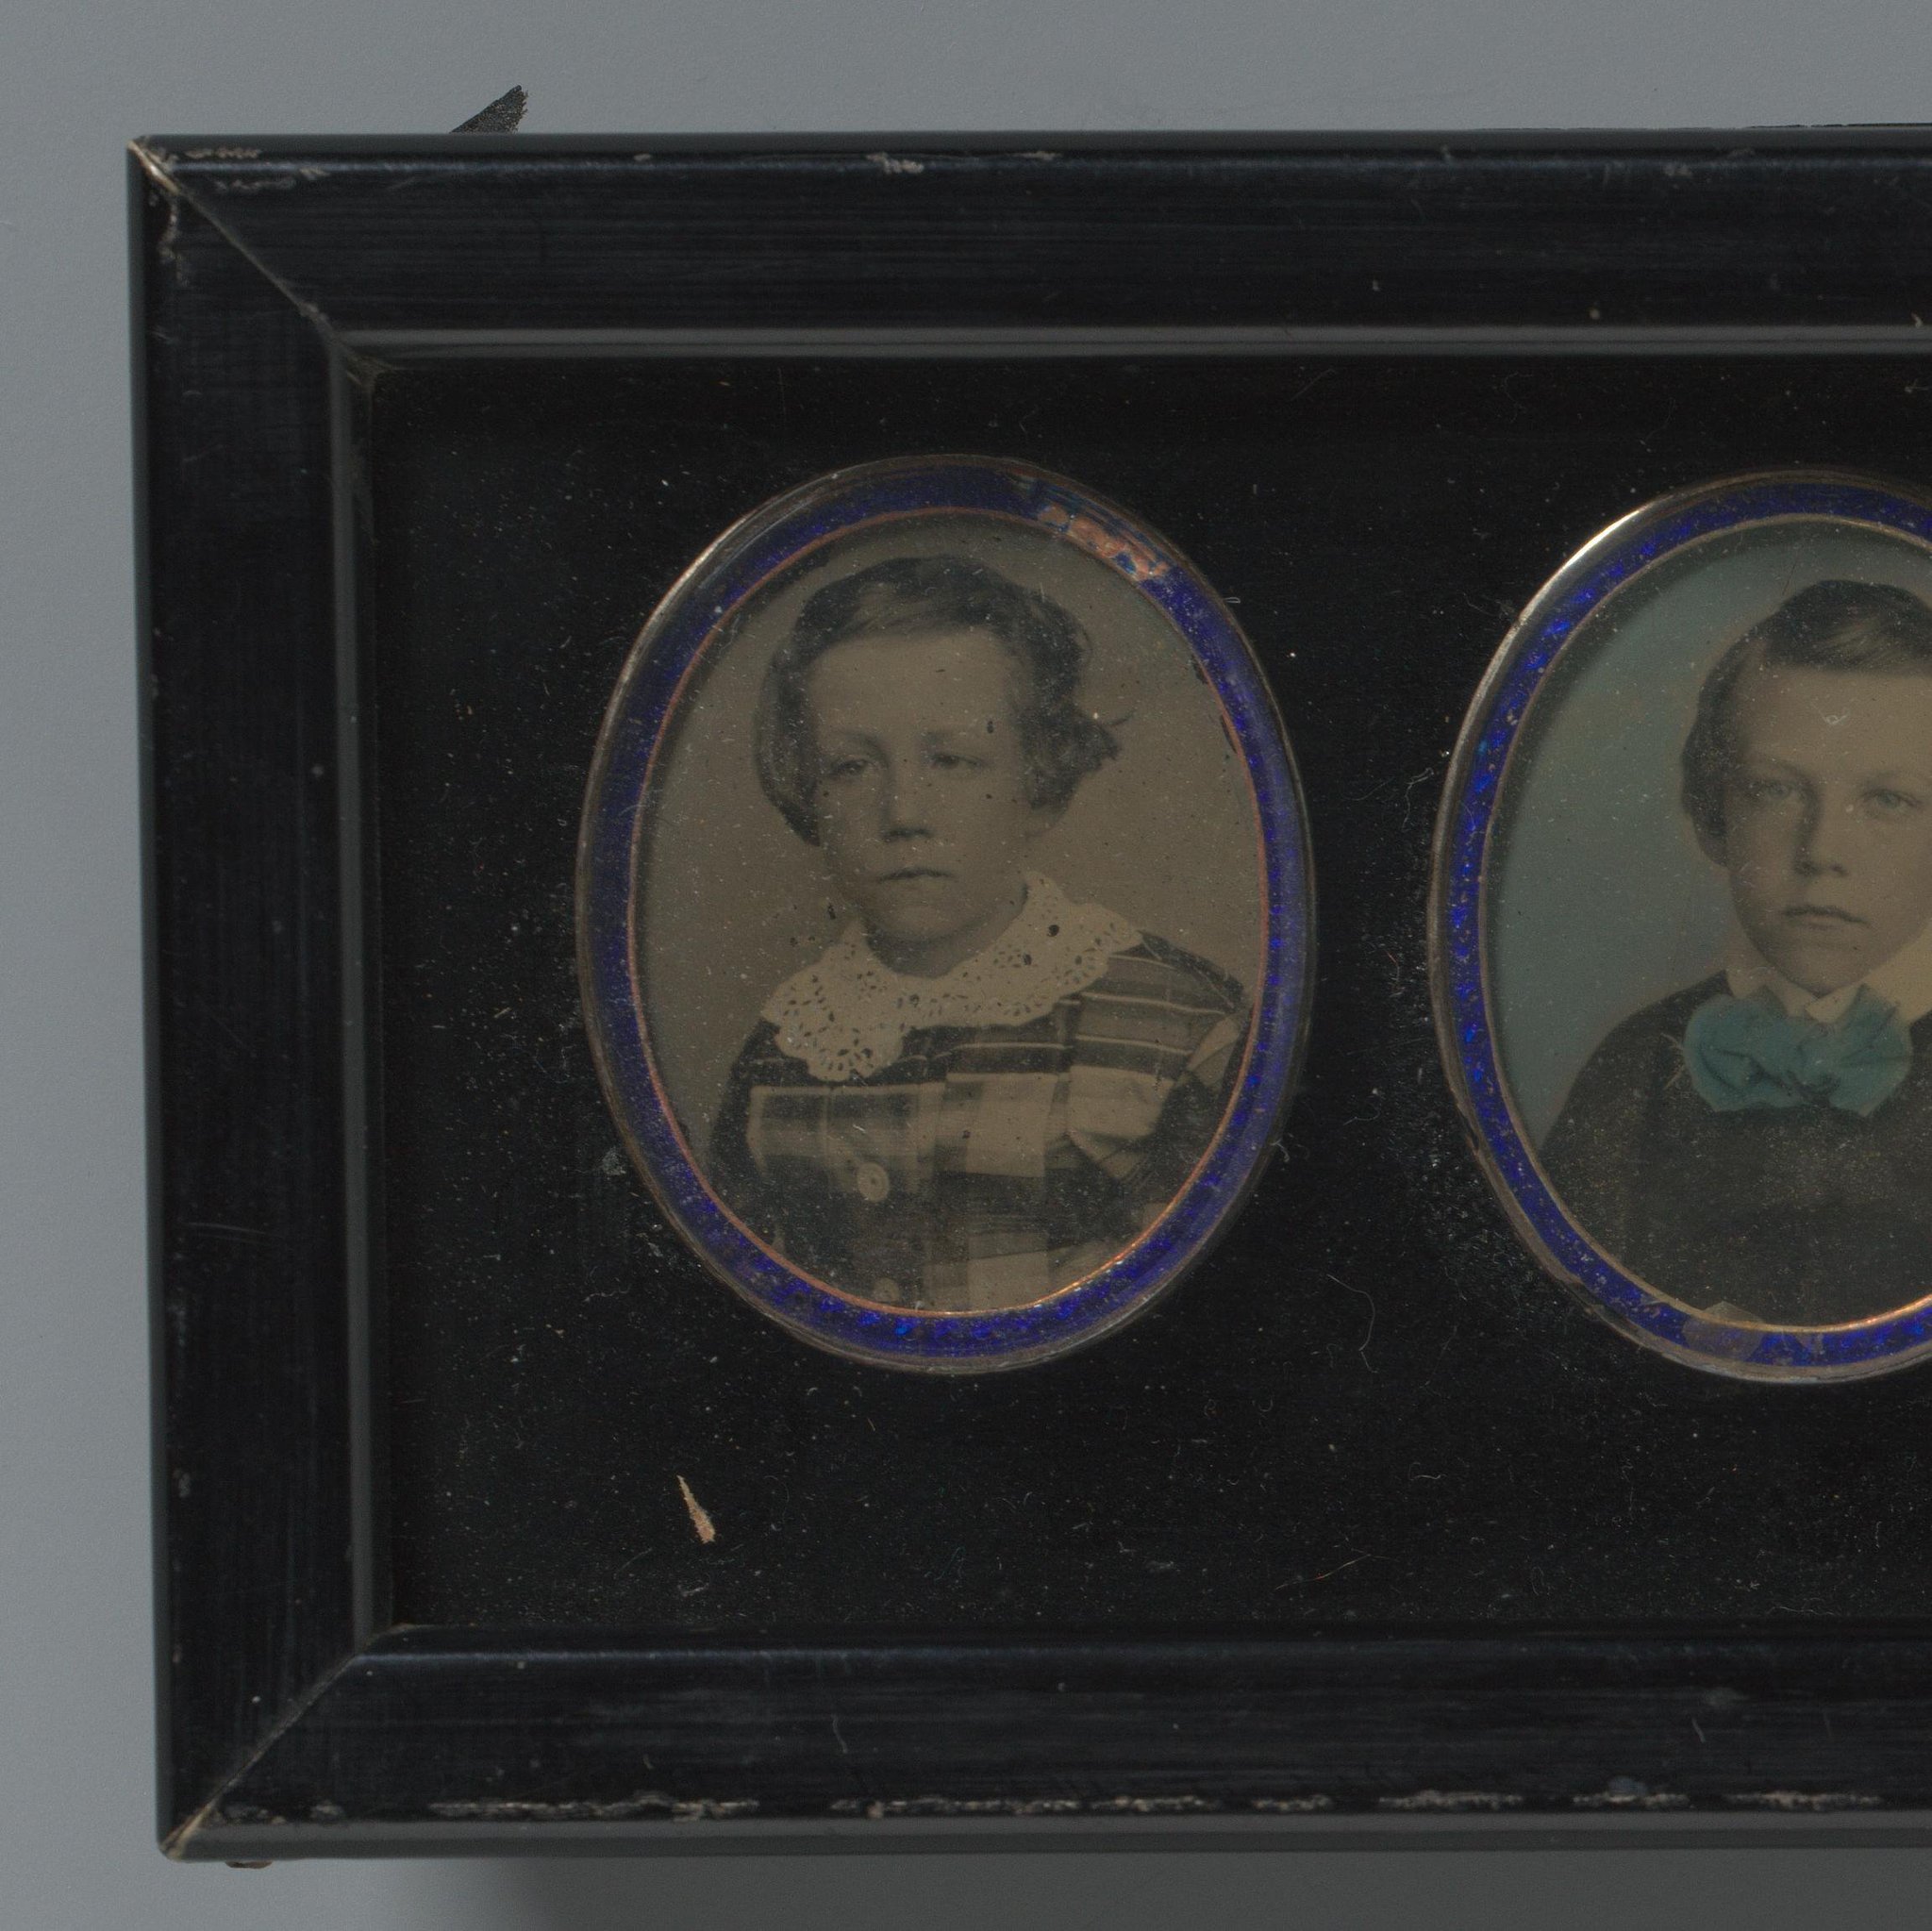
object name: frame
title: Portret van een onbekend meisje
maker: Anonymous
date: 1855-1870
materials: glass, metal, paper, wood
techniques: ambrotype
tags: historical persons - bb - woman, girl (child between toddler and youth)